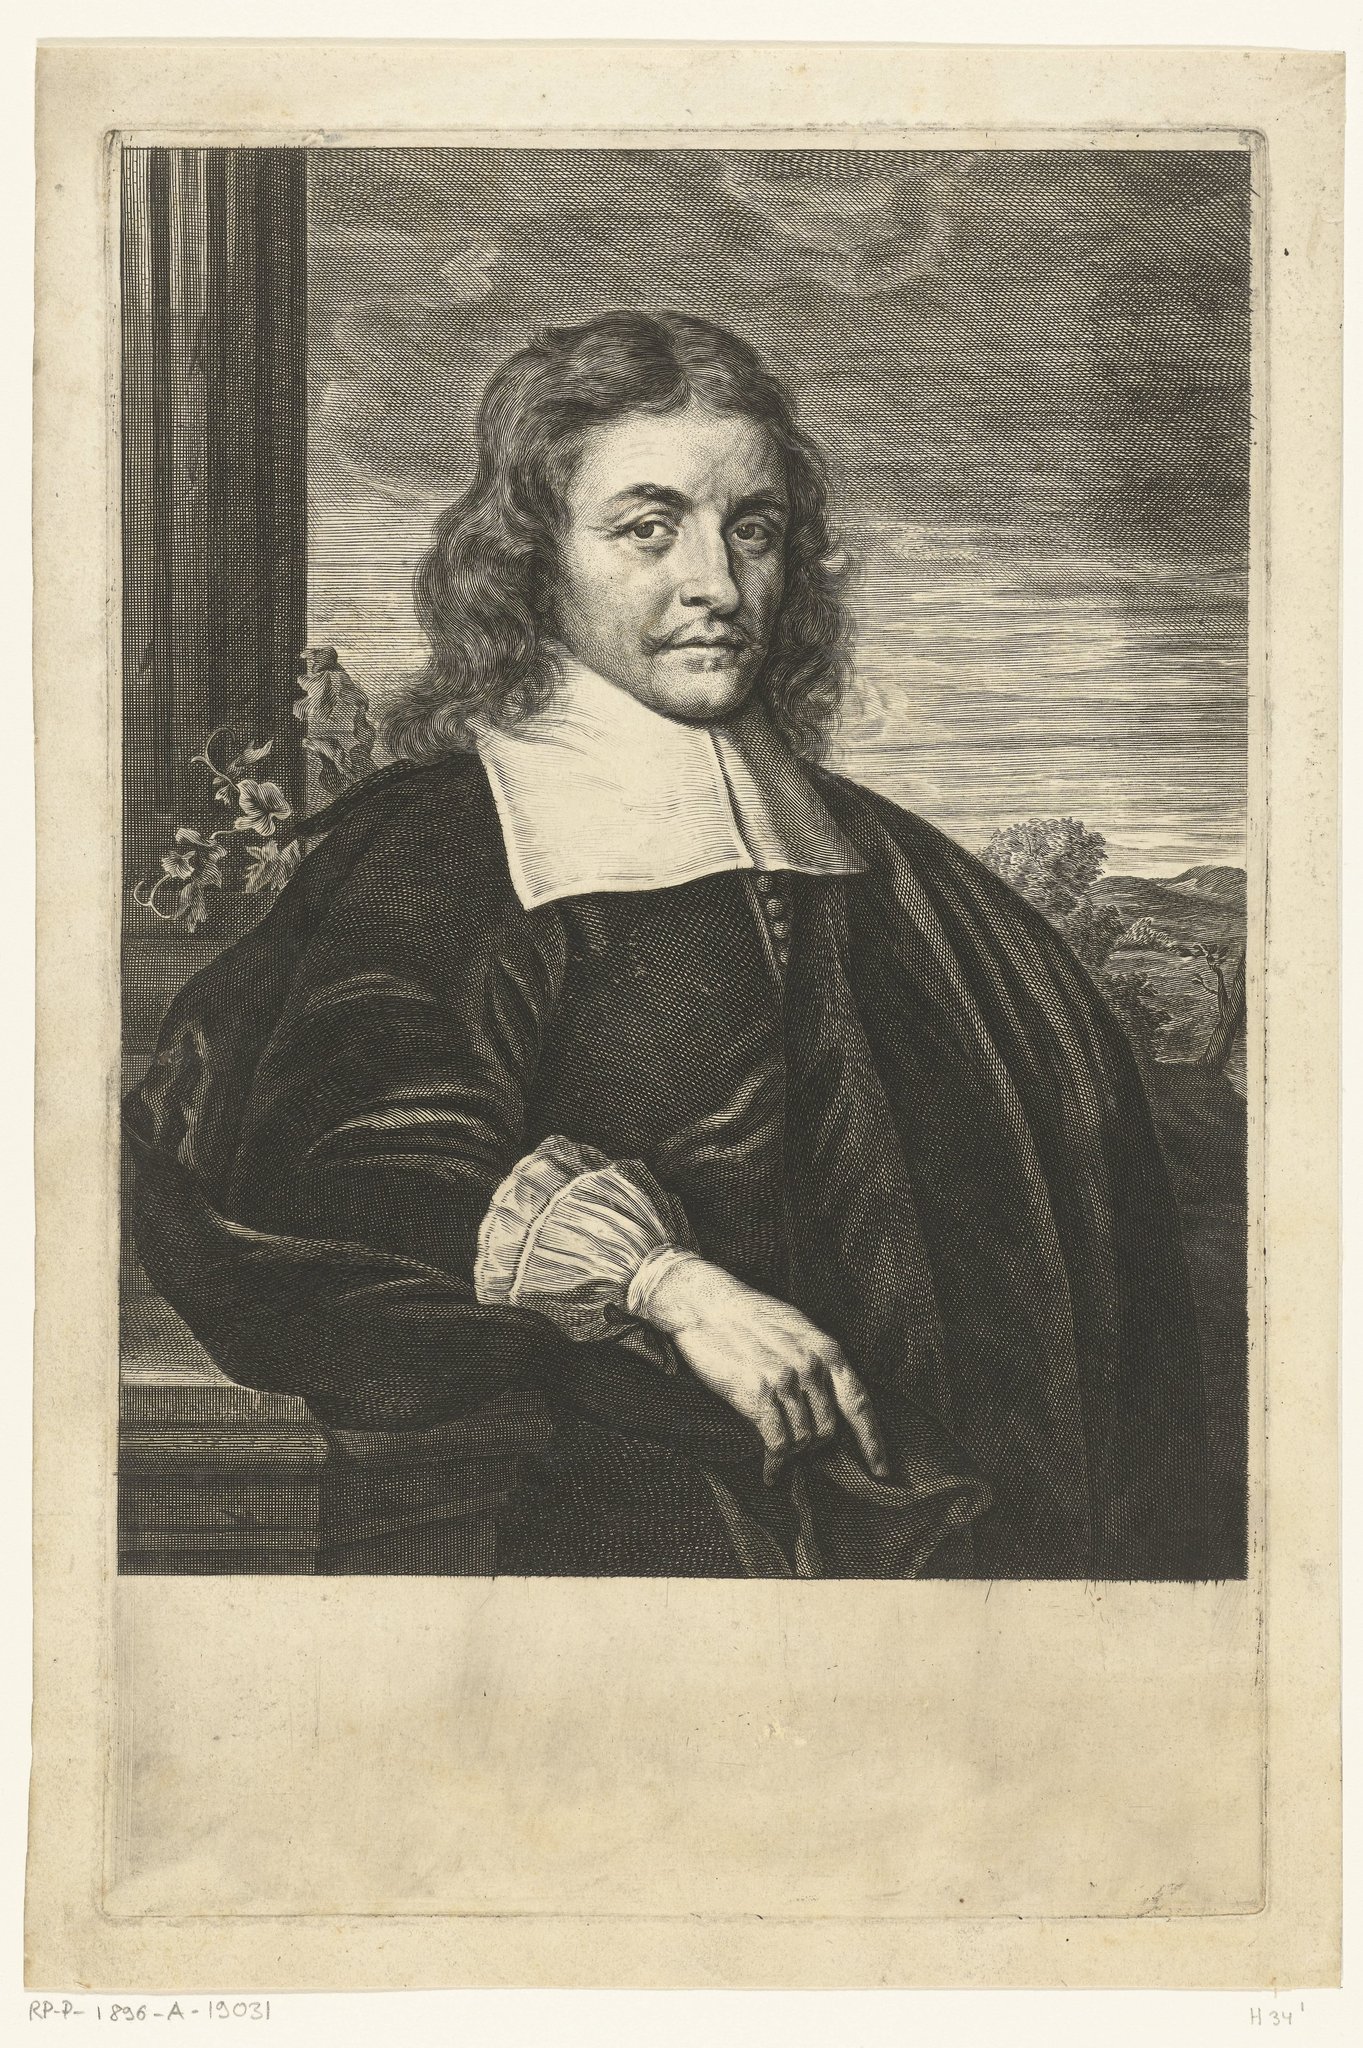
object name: print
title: Portret van Petrus Bortius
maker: hendrik bary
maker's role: draughtsman, print maker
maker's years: 1640-1707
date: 1657-1707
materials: paper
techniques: engraving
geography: netherlands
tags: jurist, petrus bortius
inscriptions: collector's mark: Lugt 2228